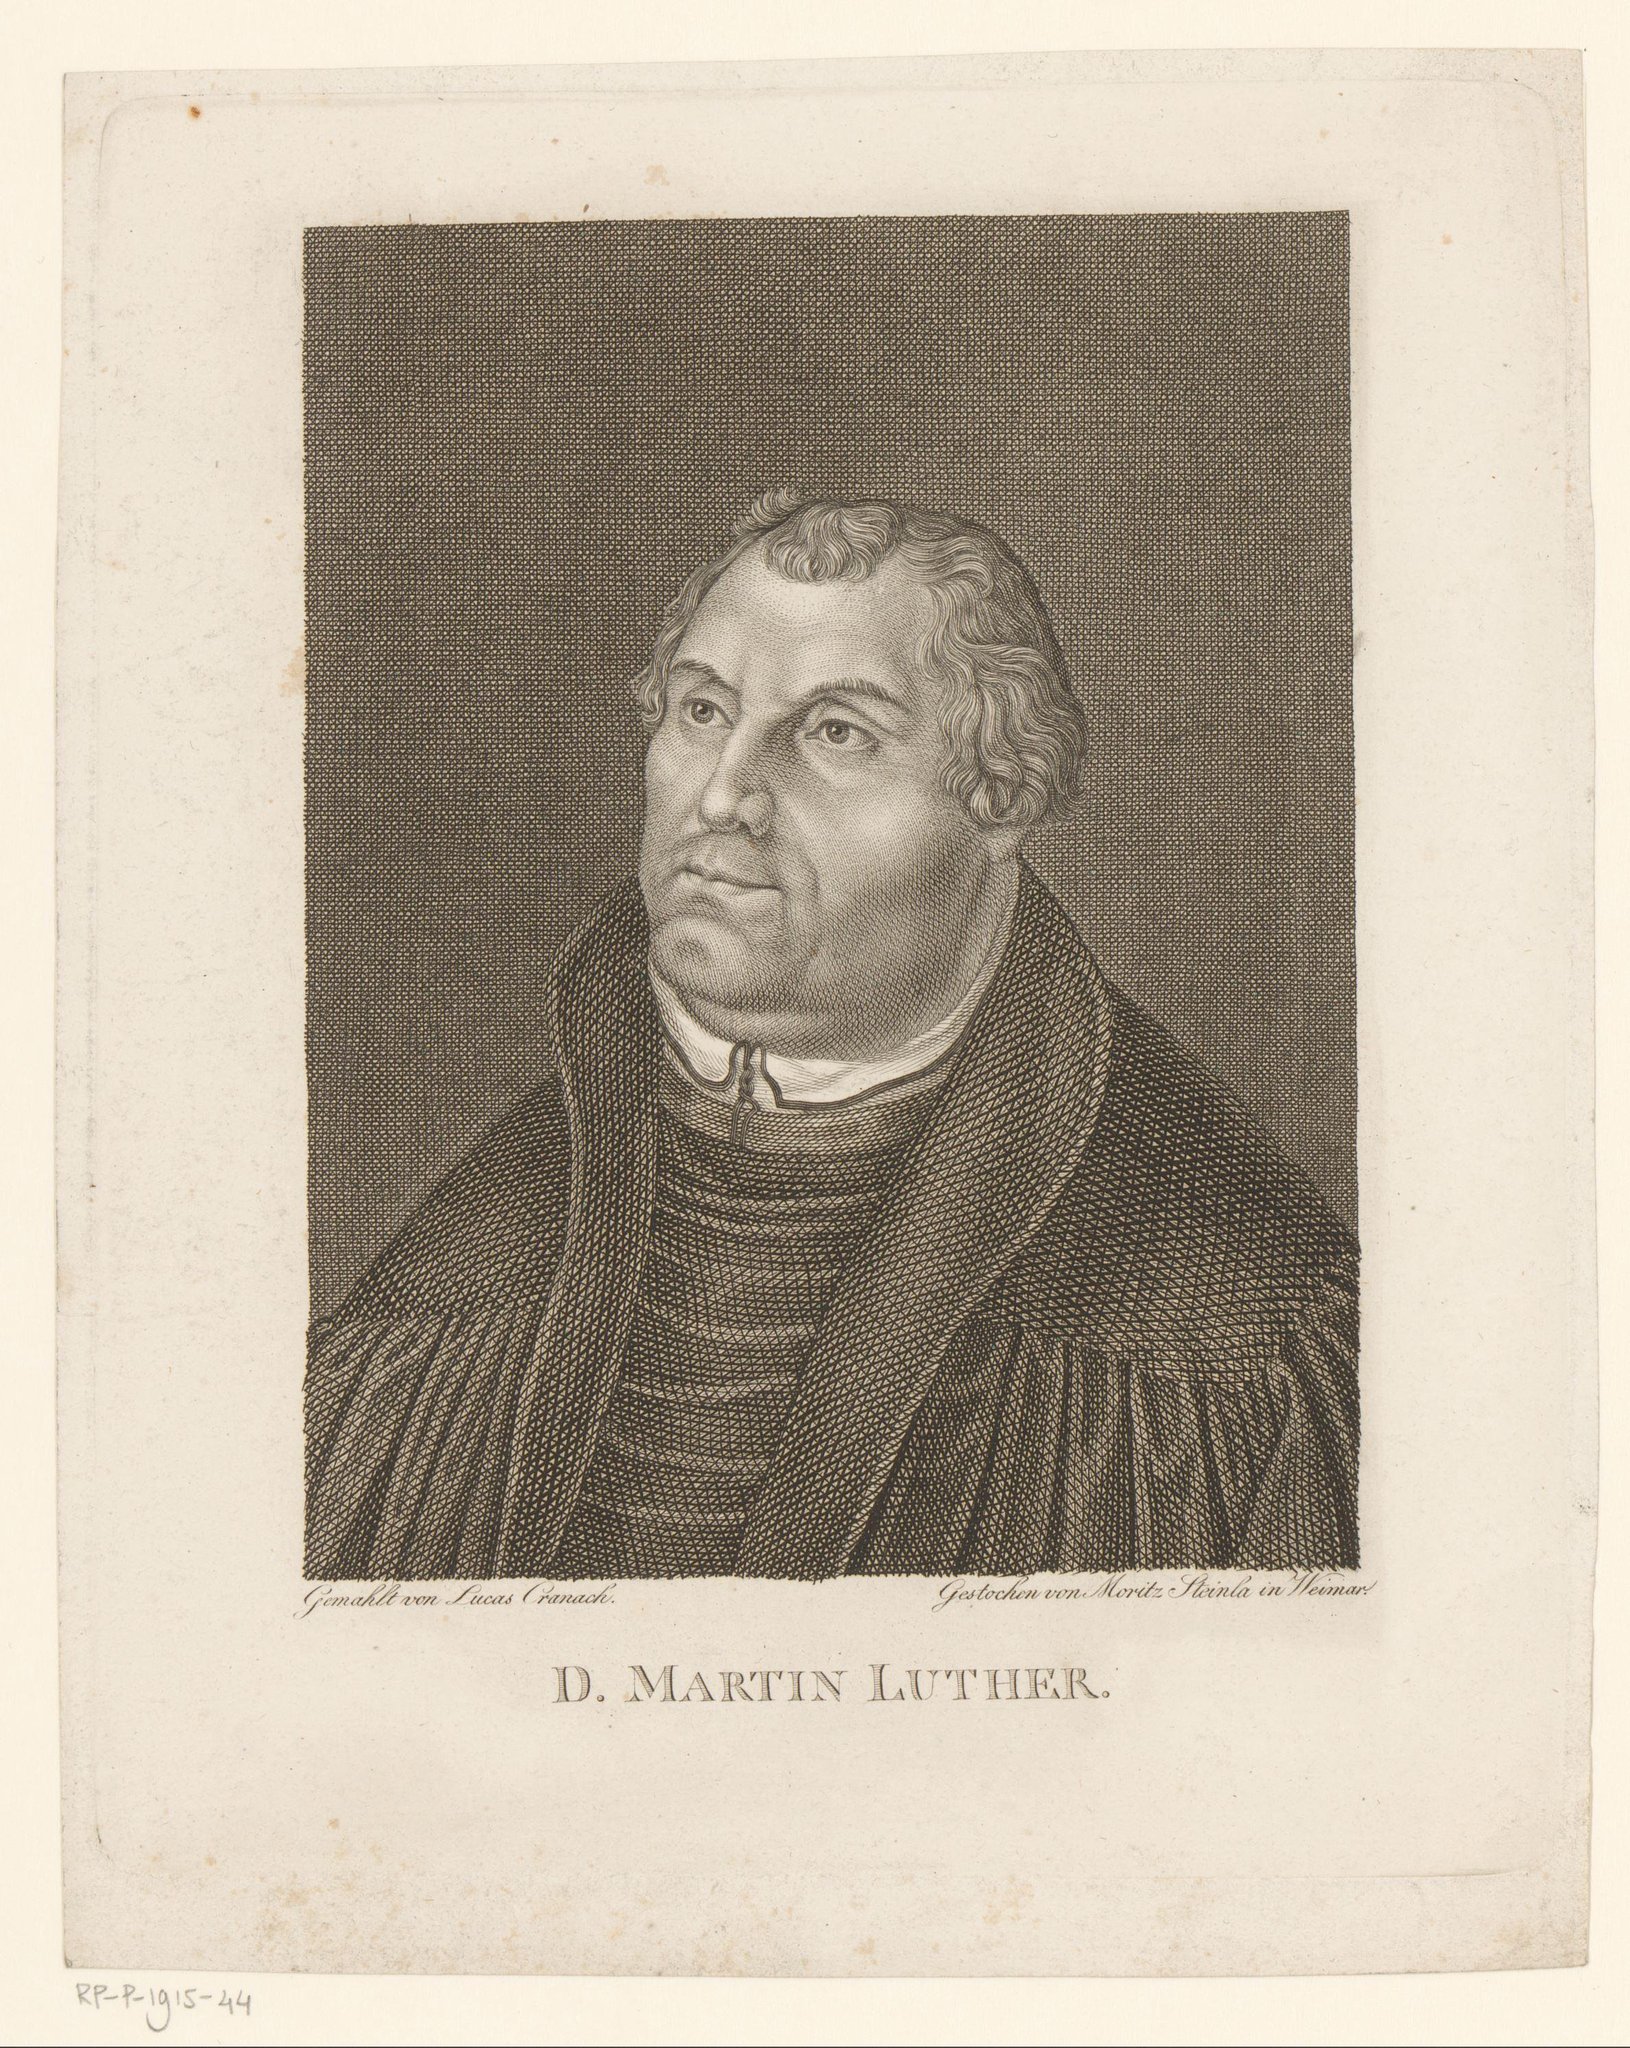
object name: print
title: Portret van Martin Luther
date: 1801-1858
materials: paper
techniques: engraving, etching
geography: weimar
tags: priest, martin luther, historical persons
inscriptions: collector's mark: Lugt 2228